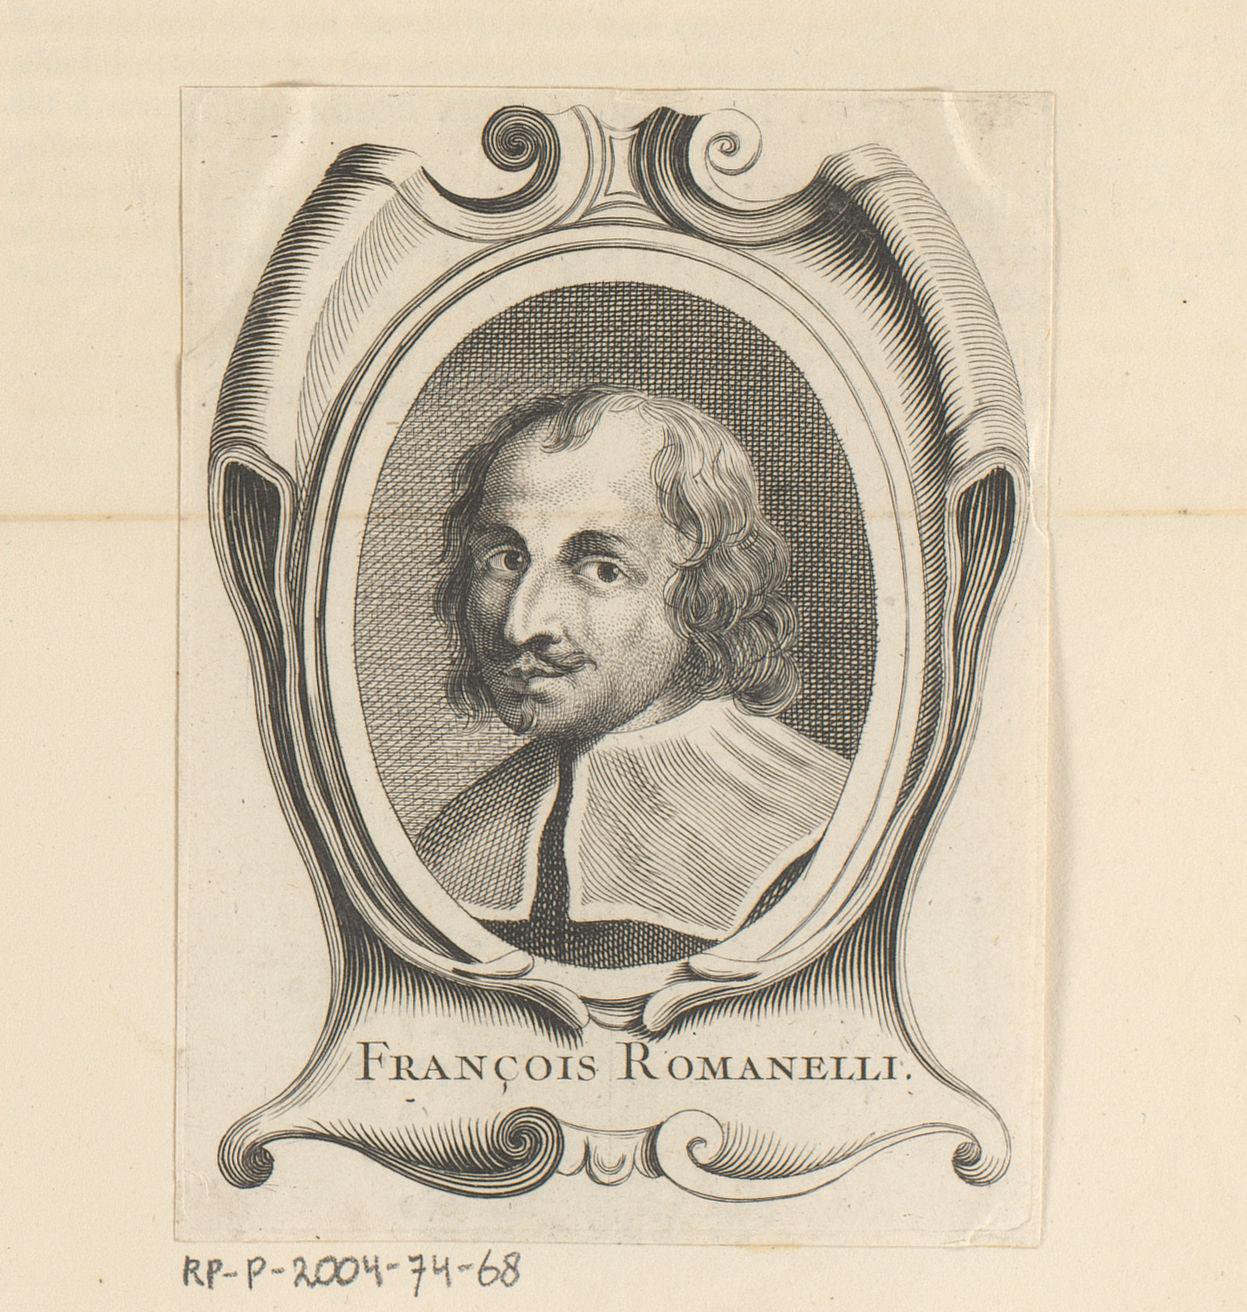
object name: album leaf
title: François Romanelli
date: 1745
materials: paper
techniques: engraving, letterpress printing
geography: paris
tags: draughtsman, giovanni francesco romanelli, historical persons, portrait, self-portrait of painter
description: Prent uit: Dézallier d'Argenville, Antoine Joseph. Abrégé de la vie des plus fameux peintres. 4 dln. Parijs: De Bure l'aîné, 1745, dl. 1, p. 48. De samensteller heeft deze prent in het album geplakt als illustratie bij: Pilkington, Matthew en Johann Heinrich Füssli. A dictionary of painters, from the revival of the art to the present period. 4 dln. Londen: John Crowder, 1805, dl. 3, p. 462.